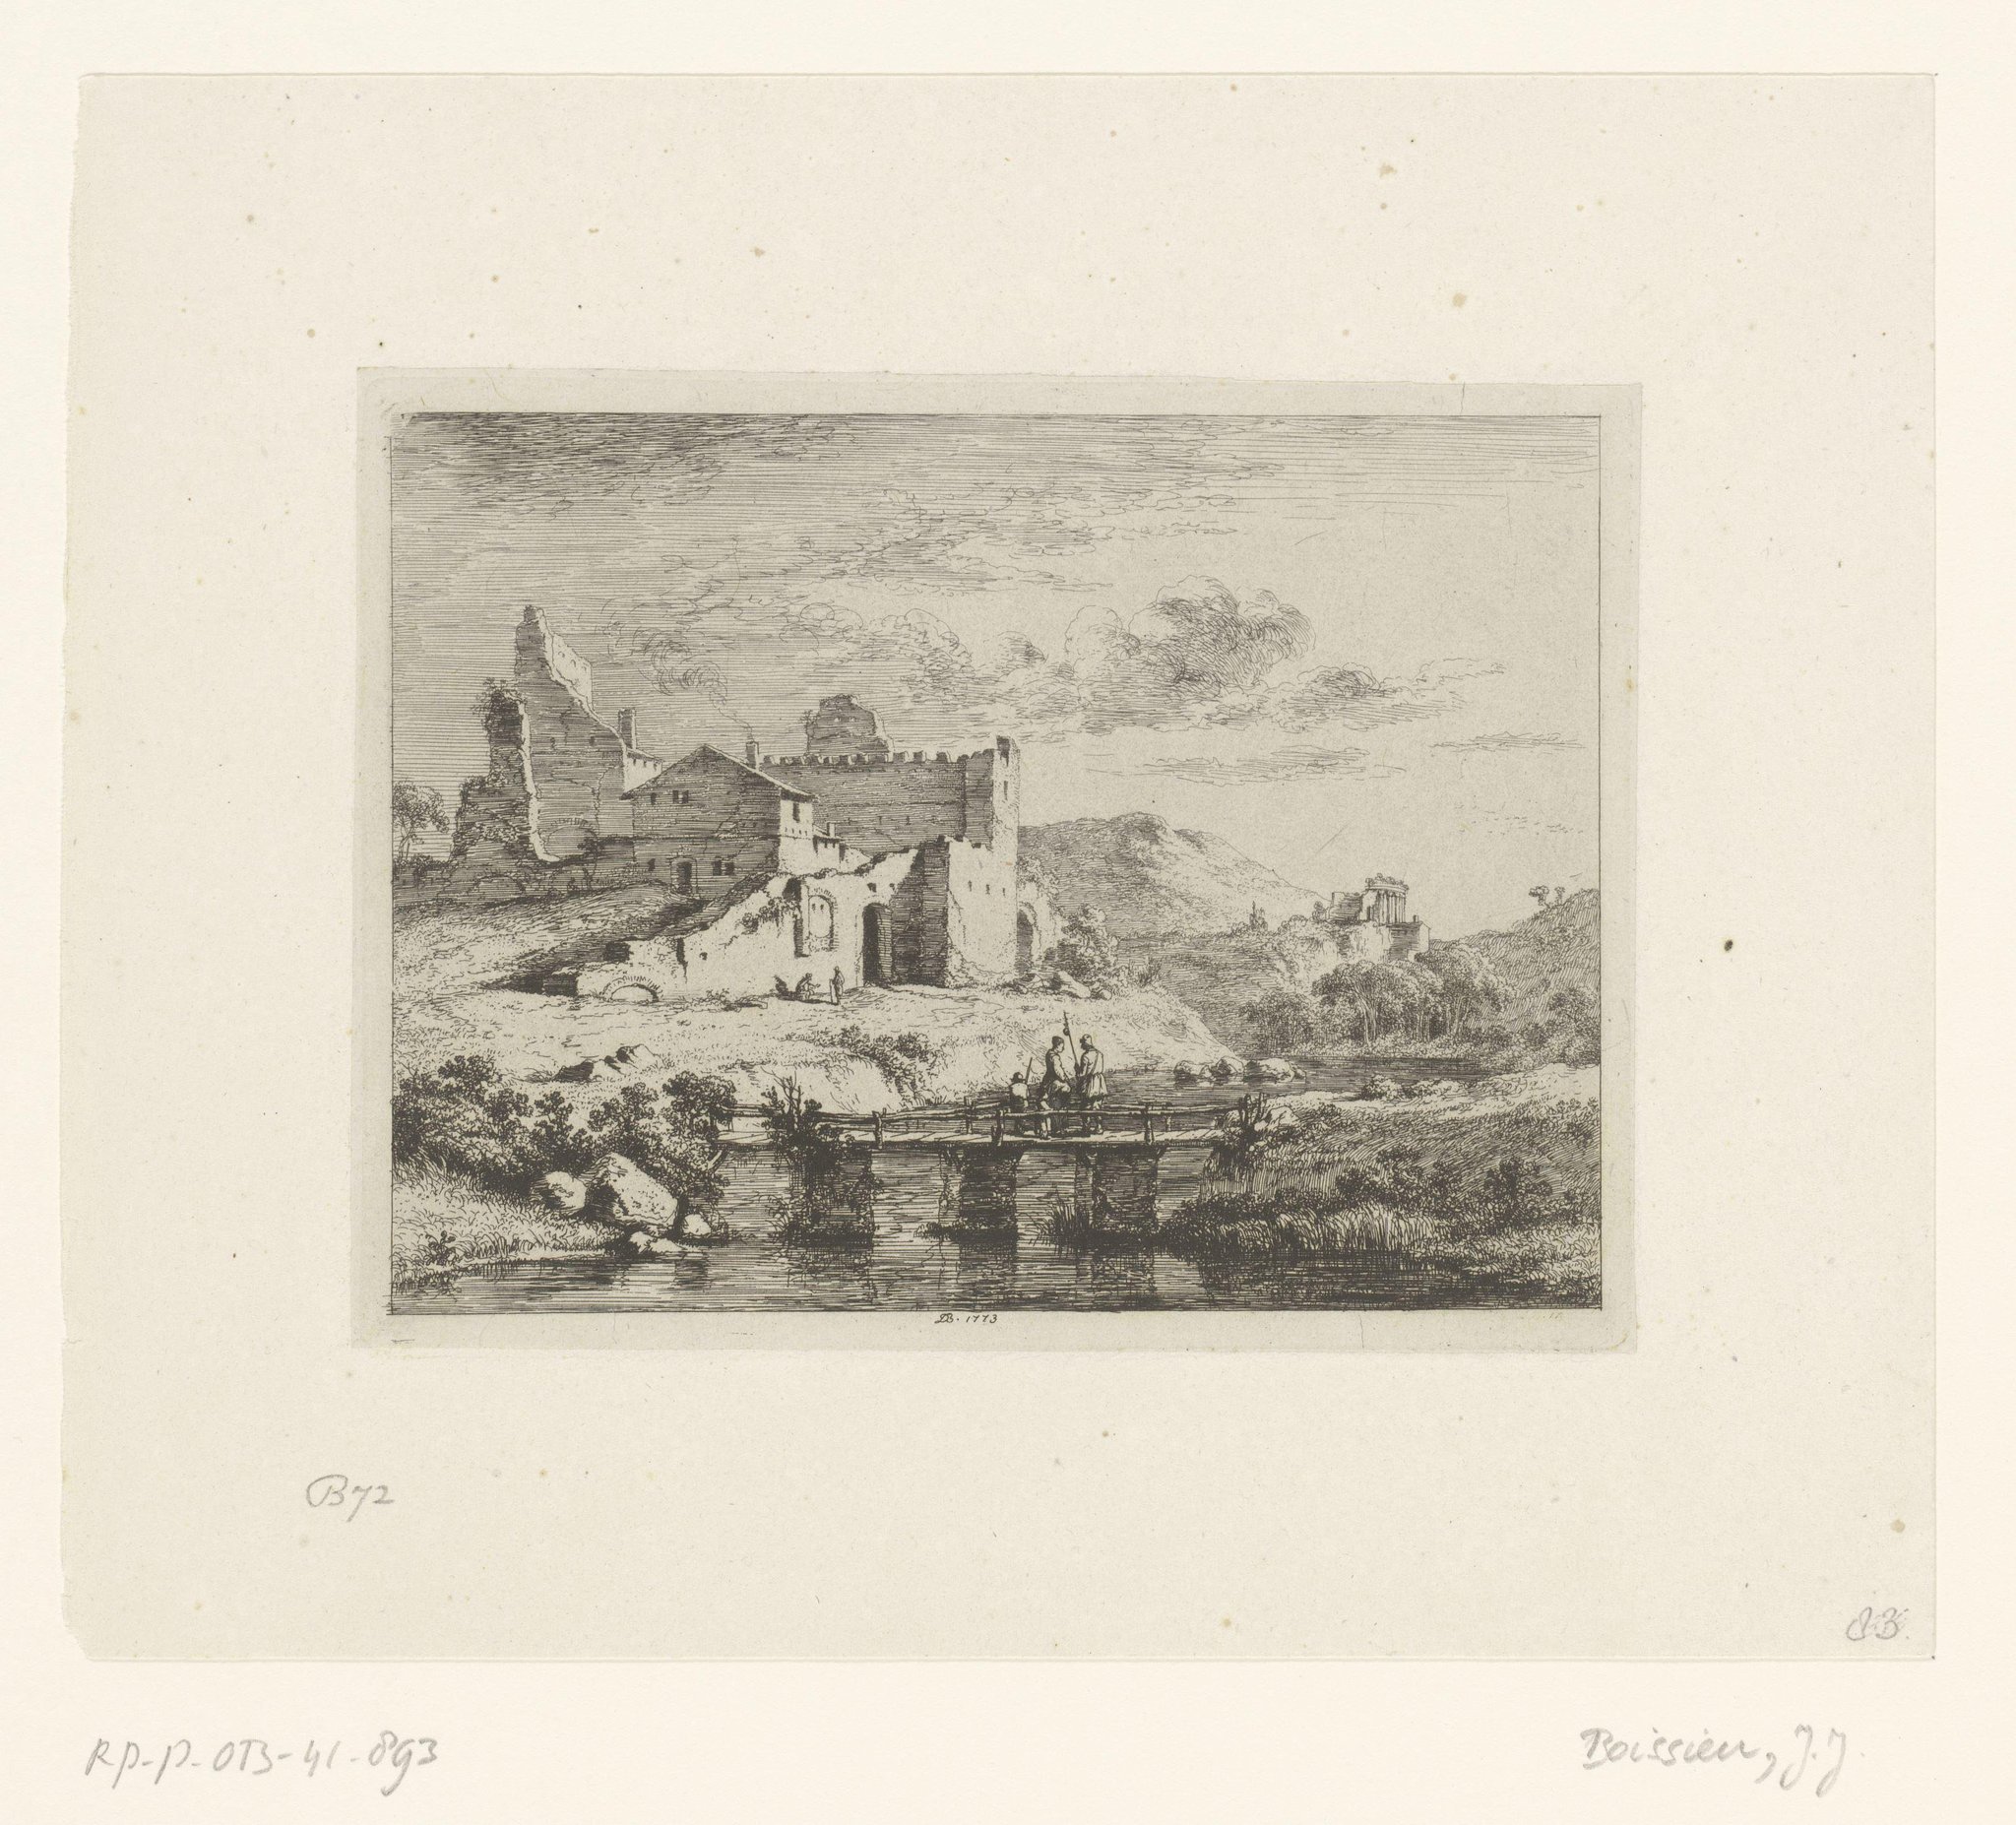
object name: print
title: Landschap met ruïnes en figuren op een brug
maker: jean jacques de boissieu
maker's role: draughtsman, print maker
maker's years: 1736-1810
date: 1773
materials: paper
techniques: etching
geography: france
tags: landscape with bridge, viaduct or aqueduct, landscape with ruins, bridge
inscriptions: collector's mark: Lugt 12